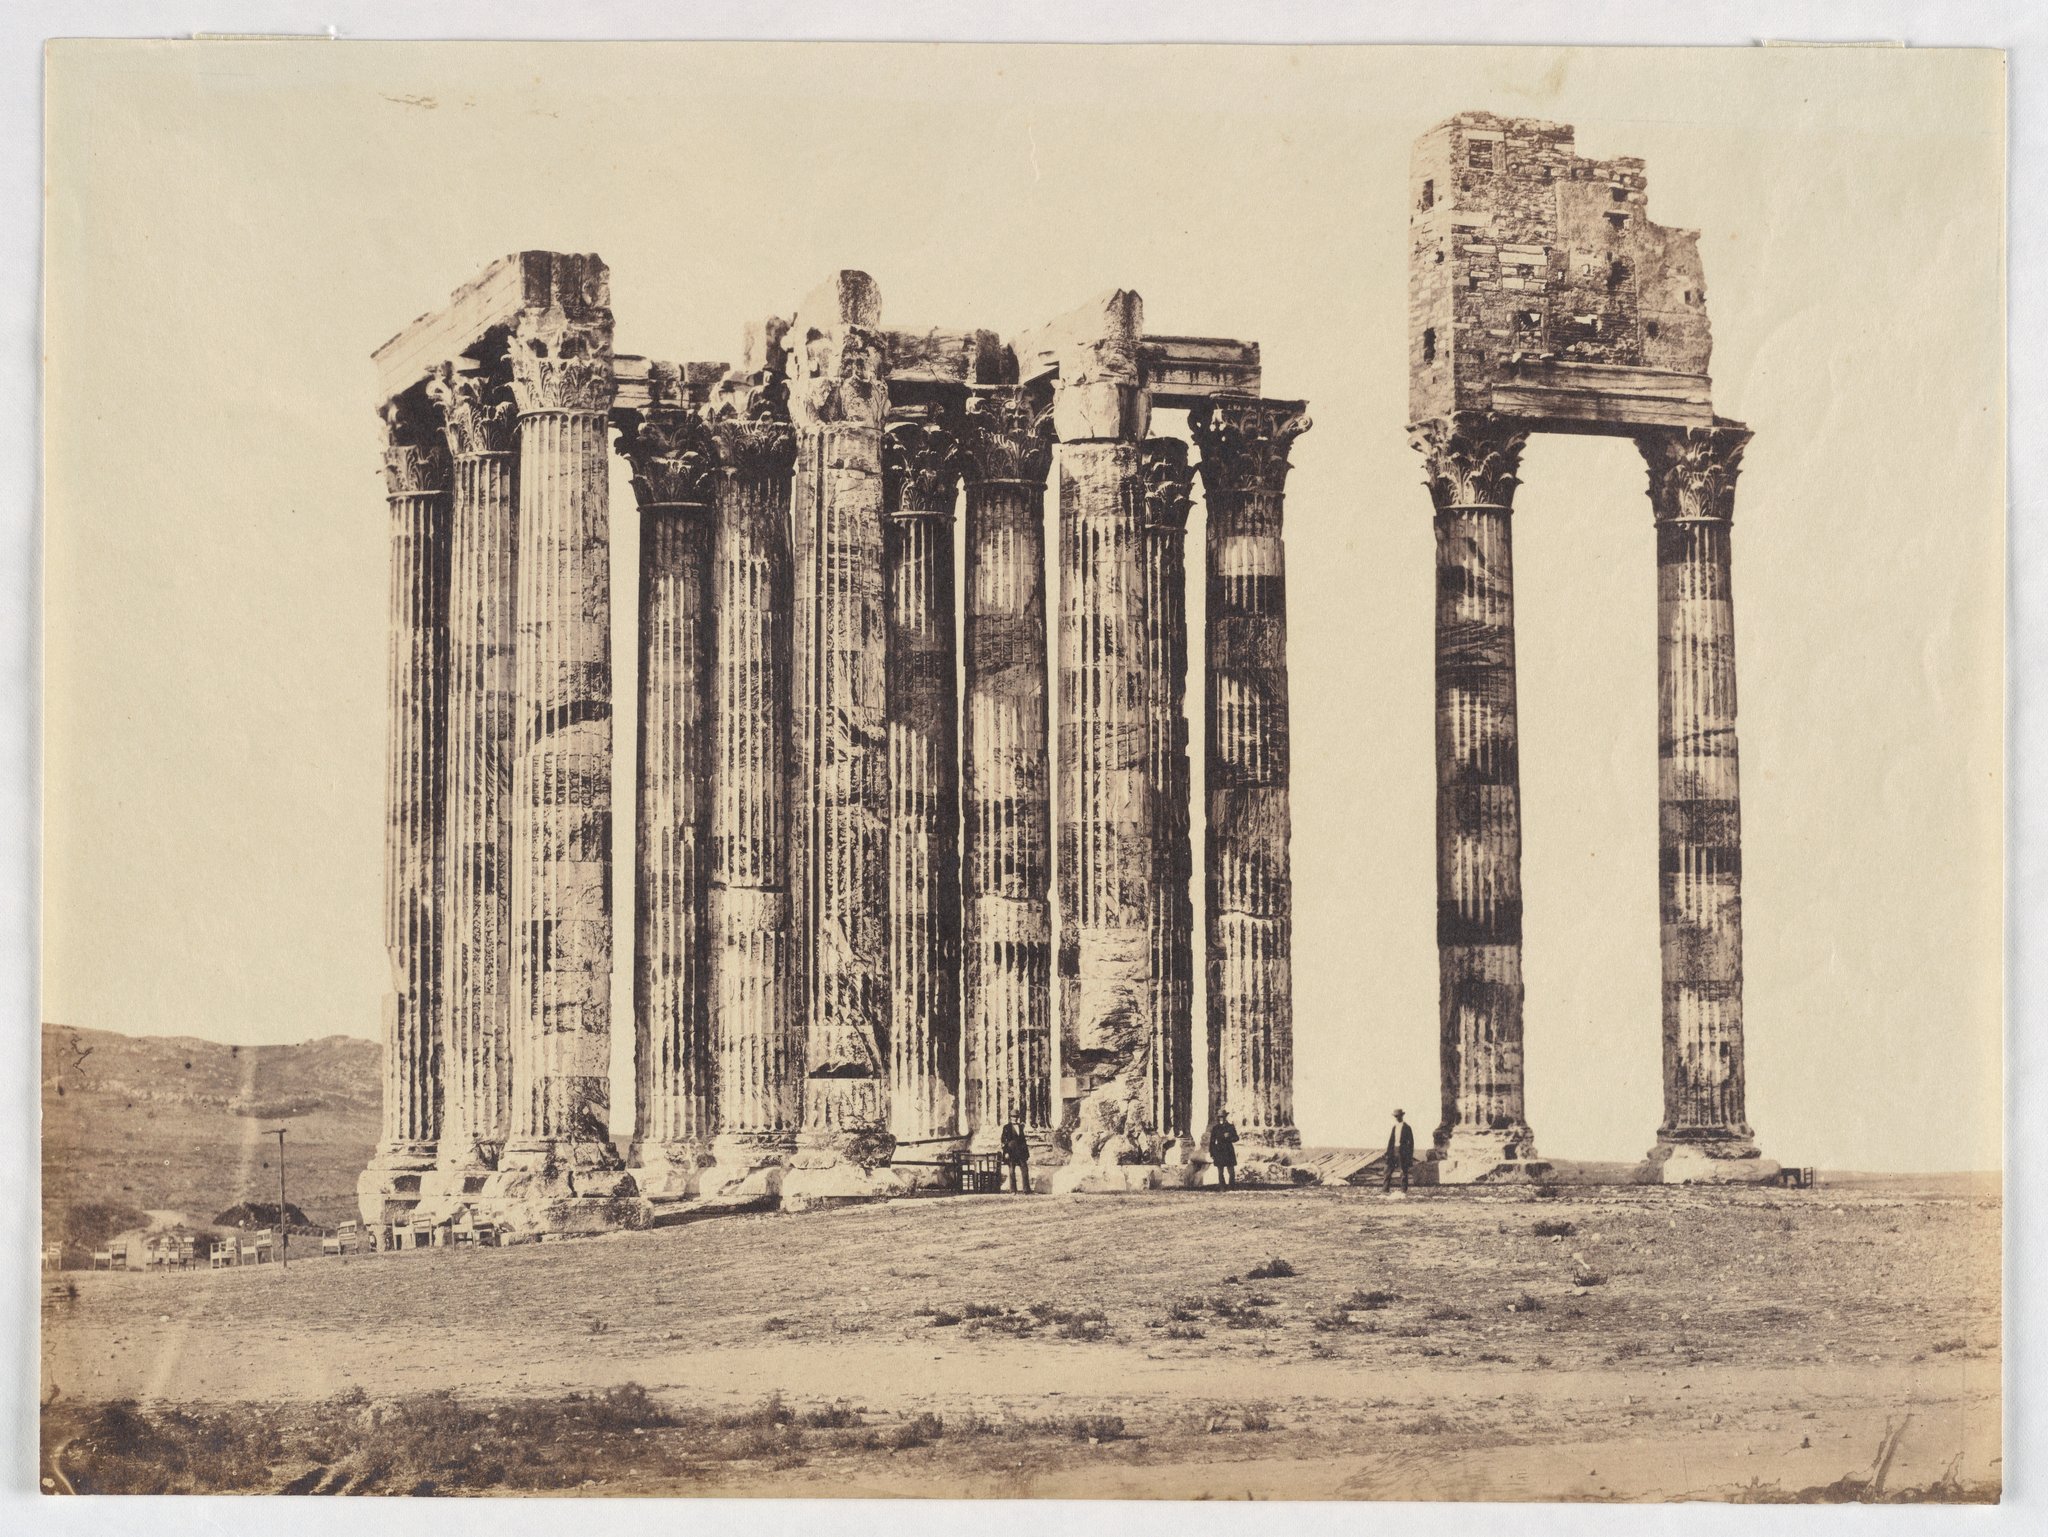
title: [Acropolis, Athens, Greece]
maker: james robertson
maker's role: artist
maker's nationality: british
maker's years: 1813-1881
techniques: salted paper print